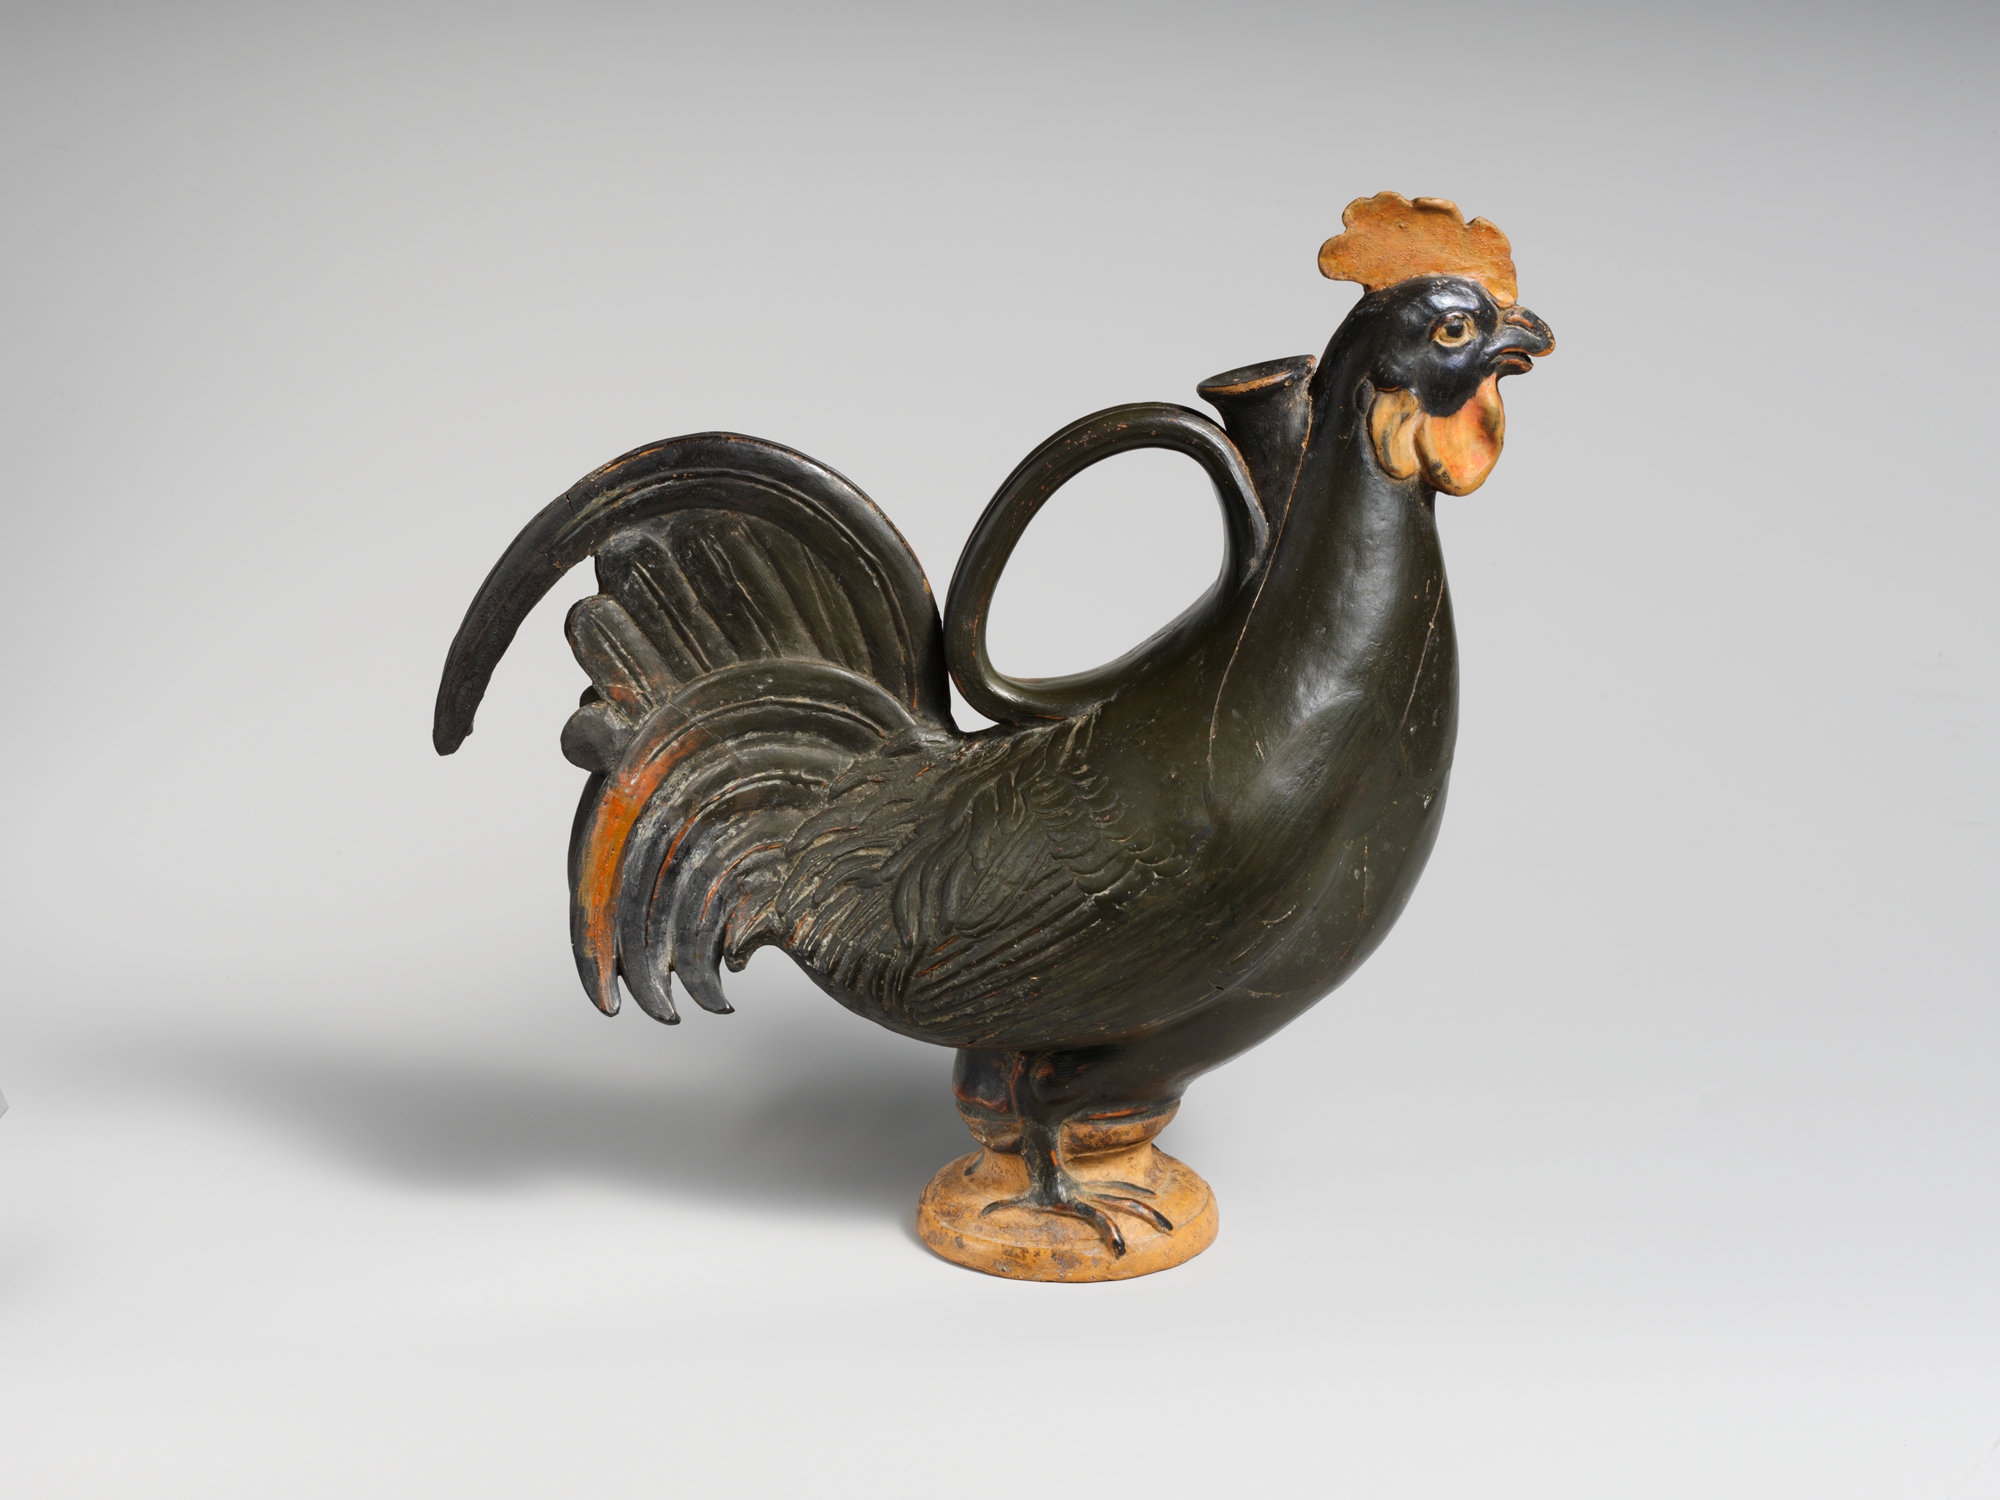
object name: askos in the form of a cock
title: Terracotta askos (flask) in the form of a rooster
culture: etruscan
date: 400-301 BCE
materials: terracotta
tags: roosters